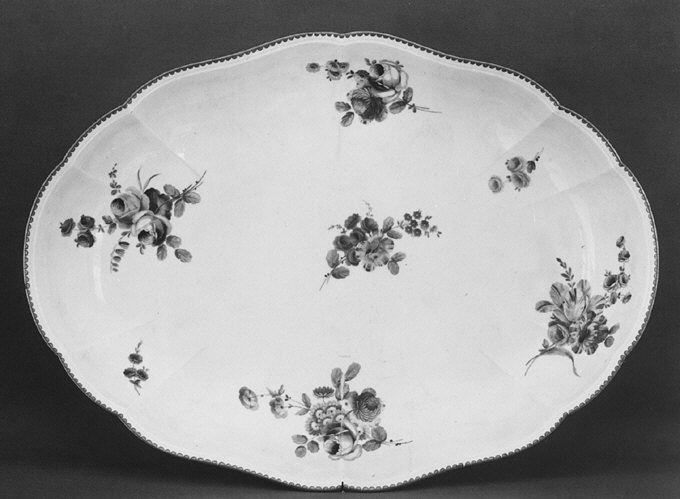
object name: platter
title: Platter (?)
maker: sèvres manufactory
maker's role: manufactory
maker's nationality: french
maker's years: 1740-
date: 1775-1780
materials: soft paste porcelain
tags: flowers